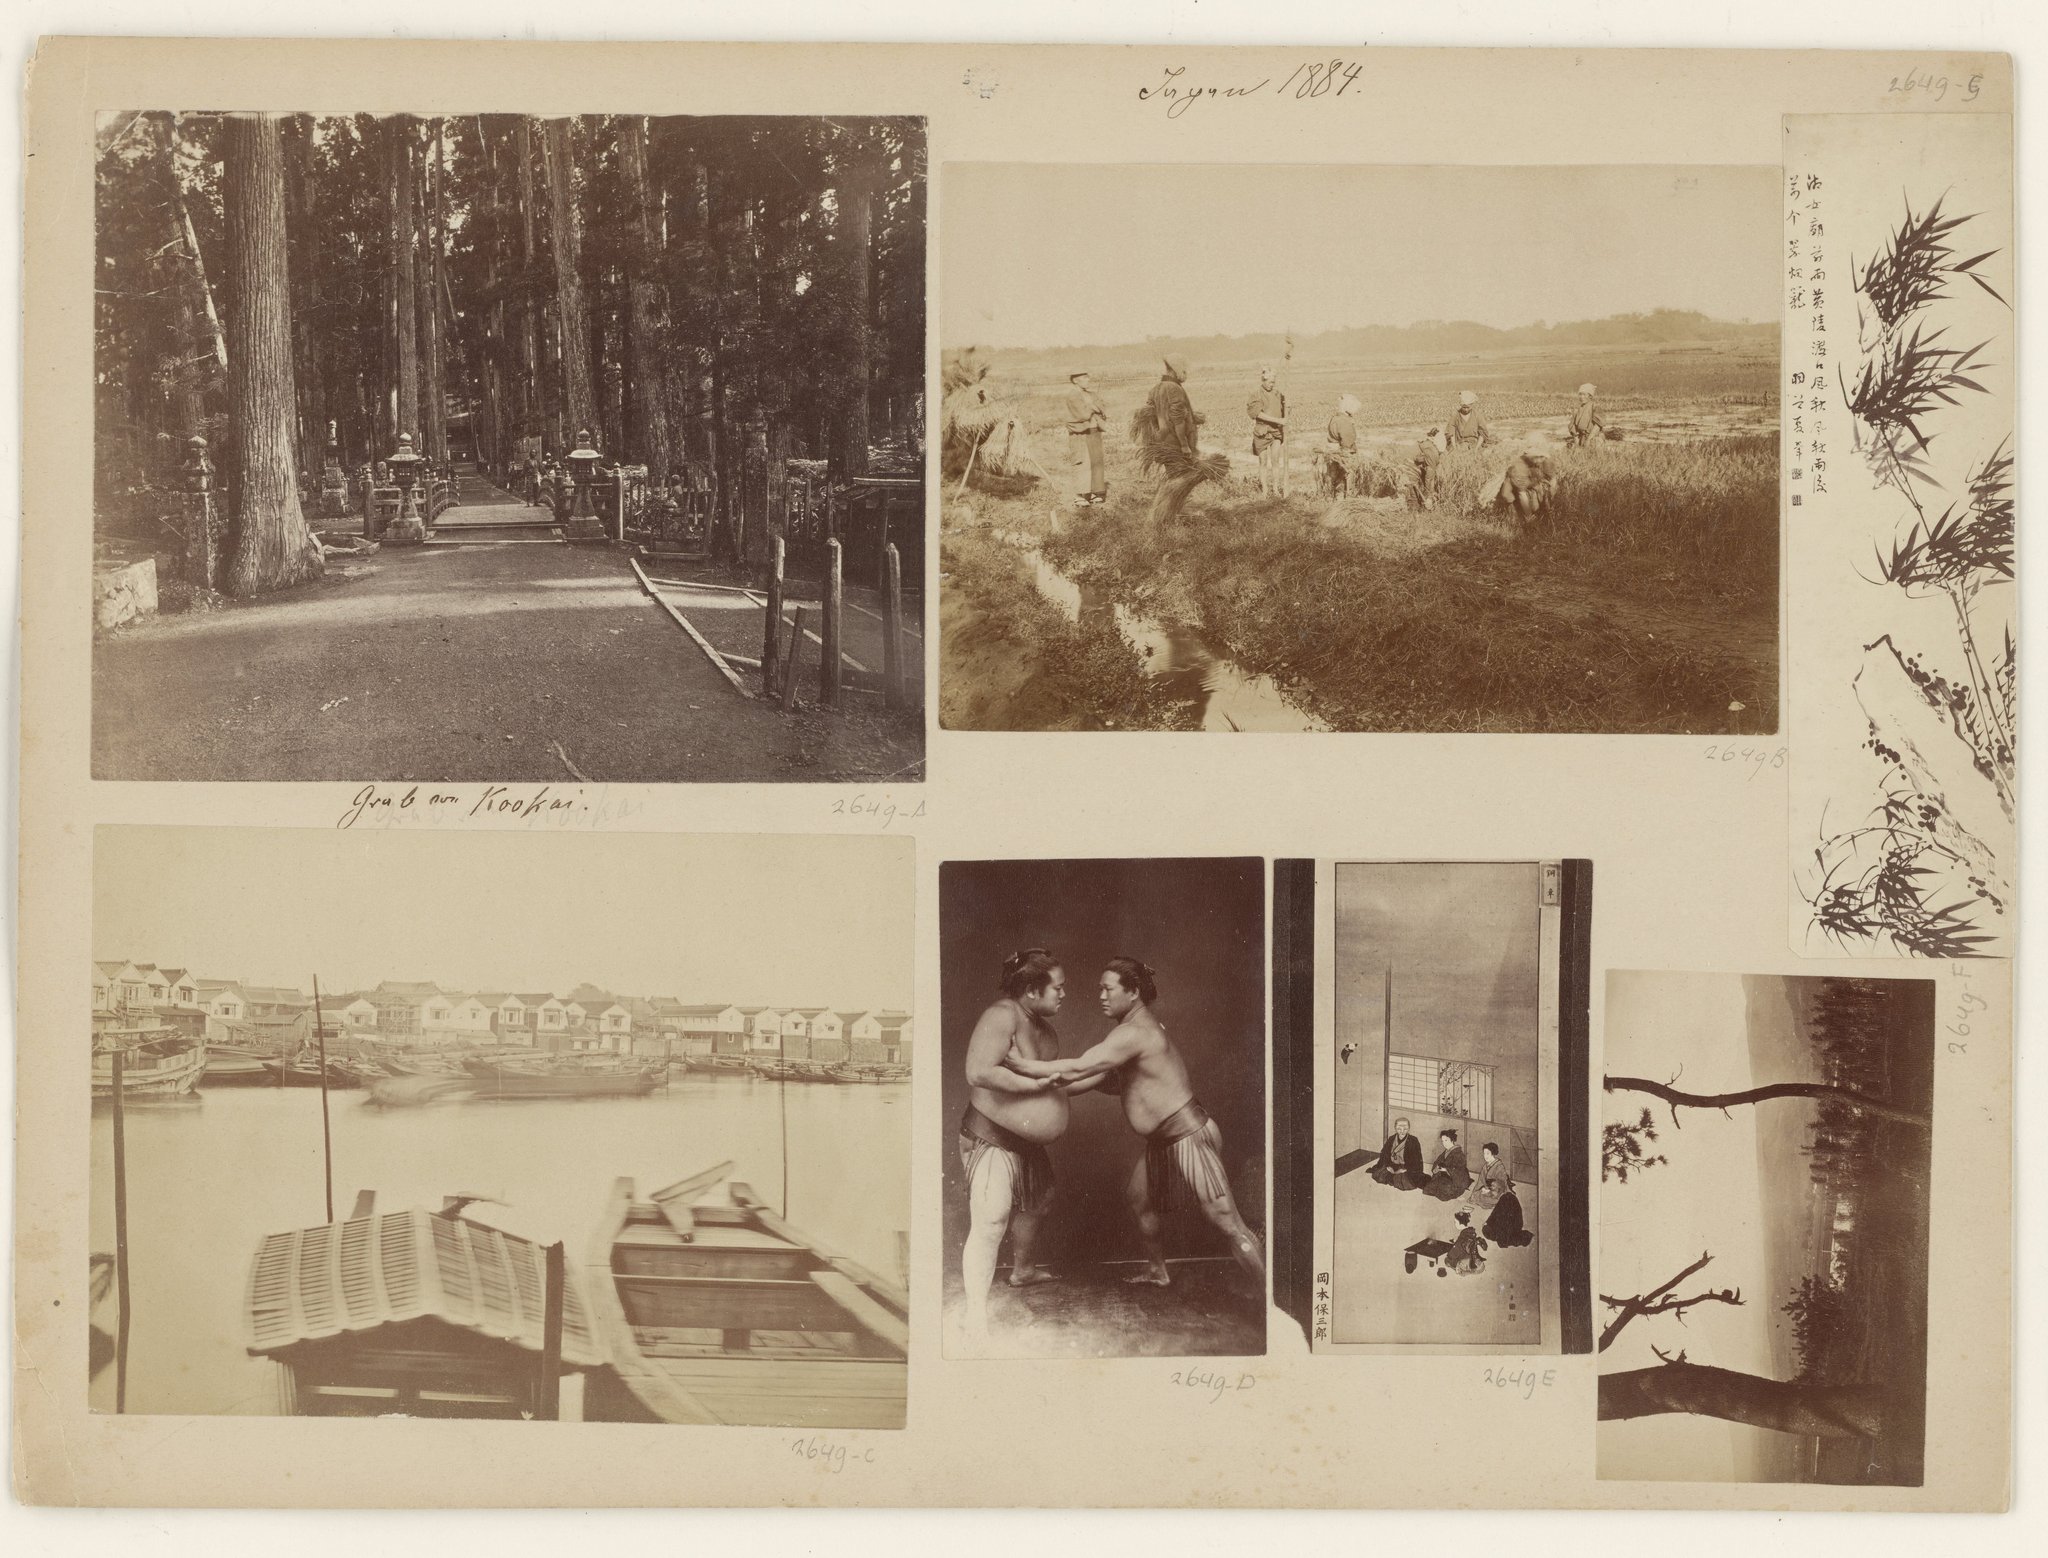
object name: photograph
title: Japan 1884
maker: Anonymous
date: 1884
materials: cardboard, paper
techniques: albumen print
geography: japan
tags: wrestling (sport) (+ the contest (sports, games, etc.)), japan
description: Onderdeel van een blad met zeven foto's.